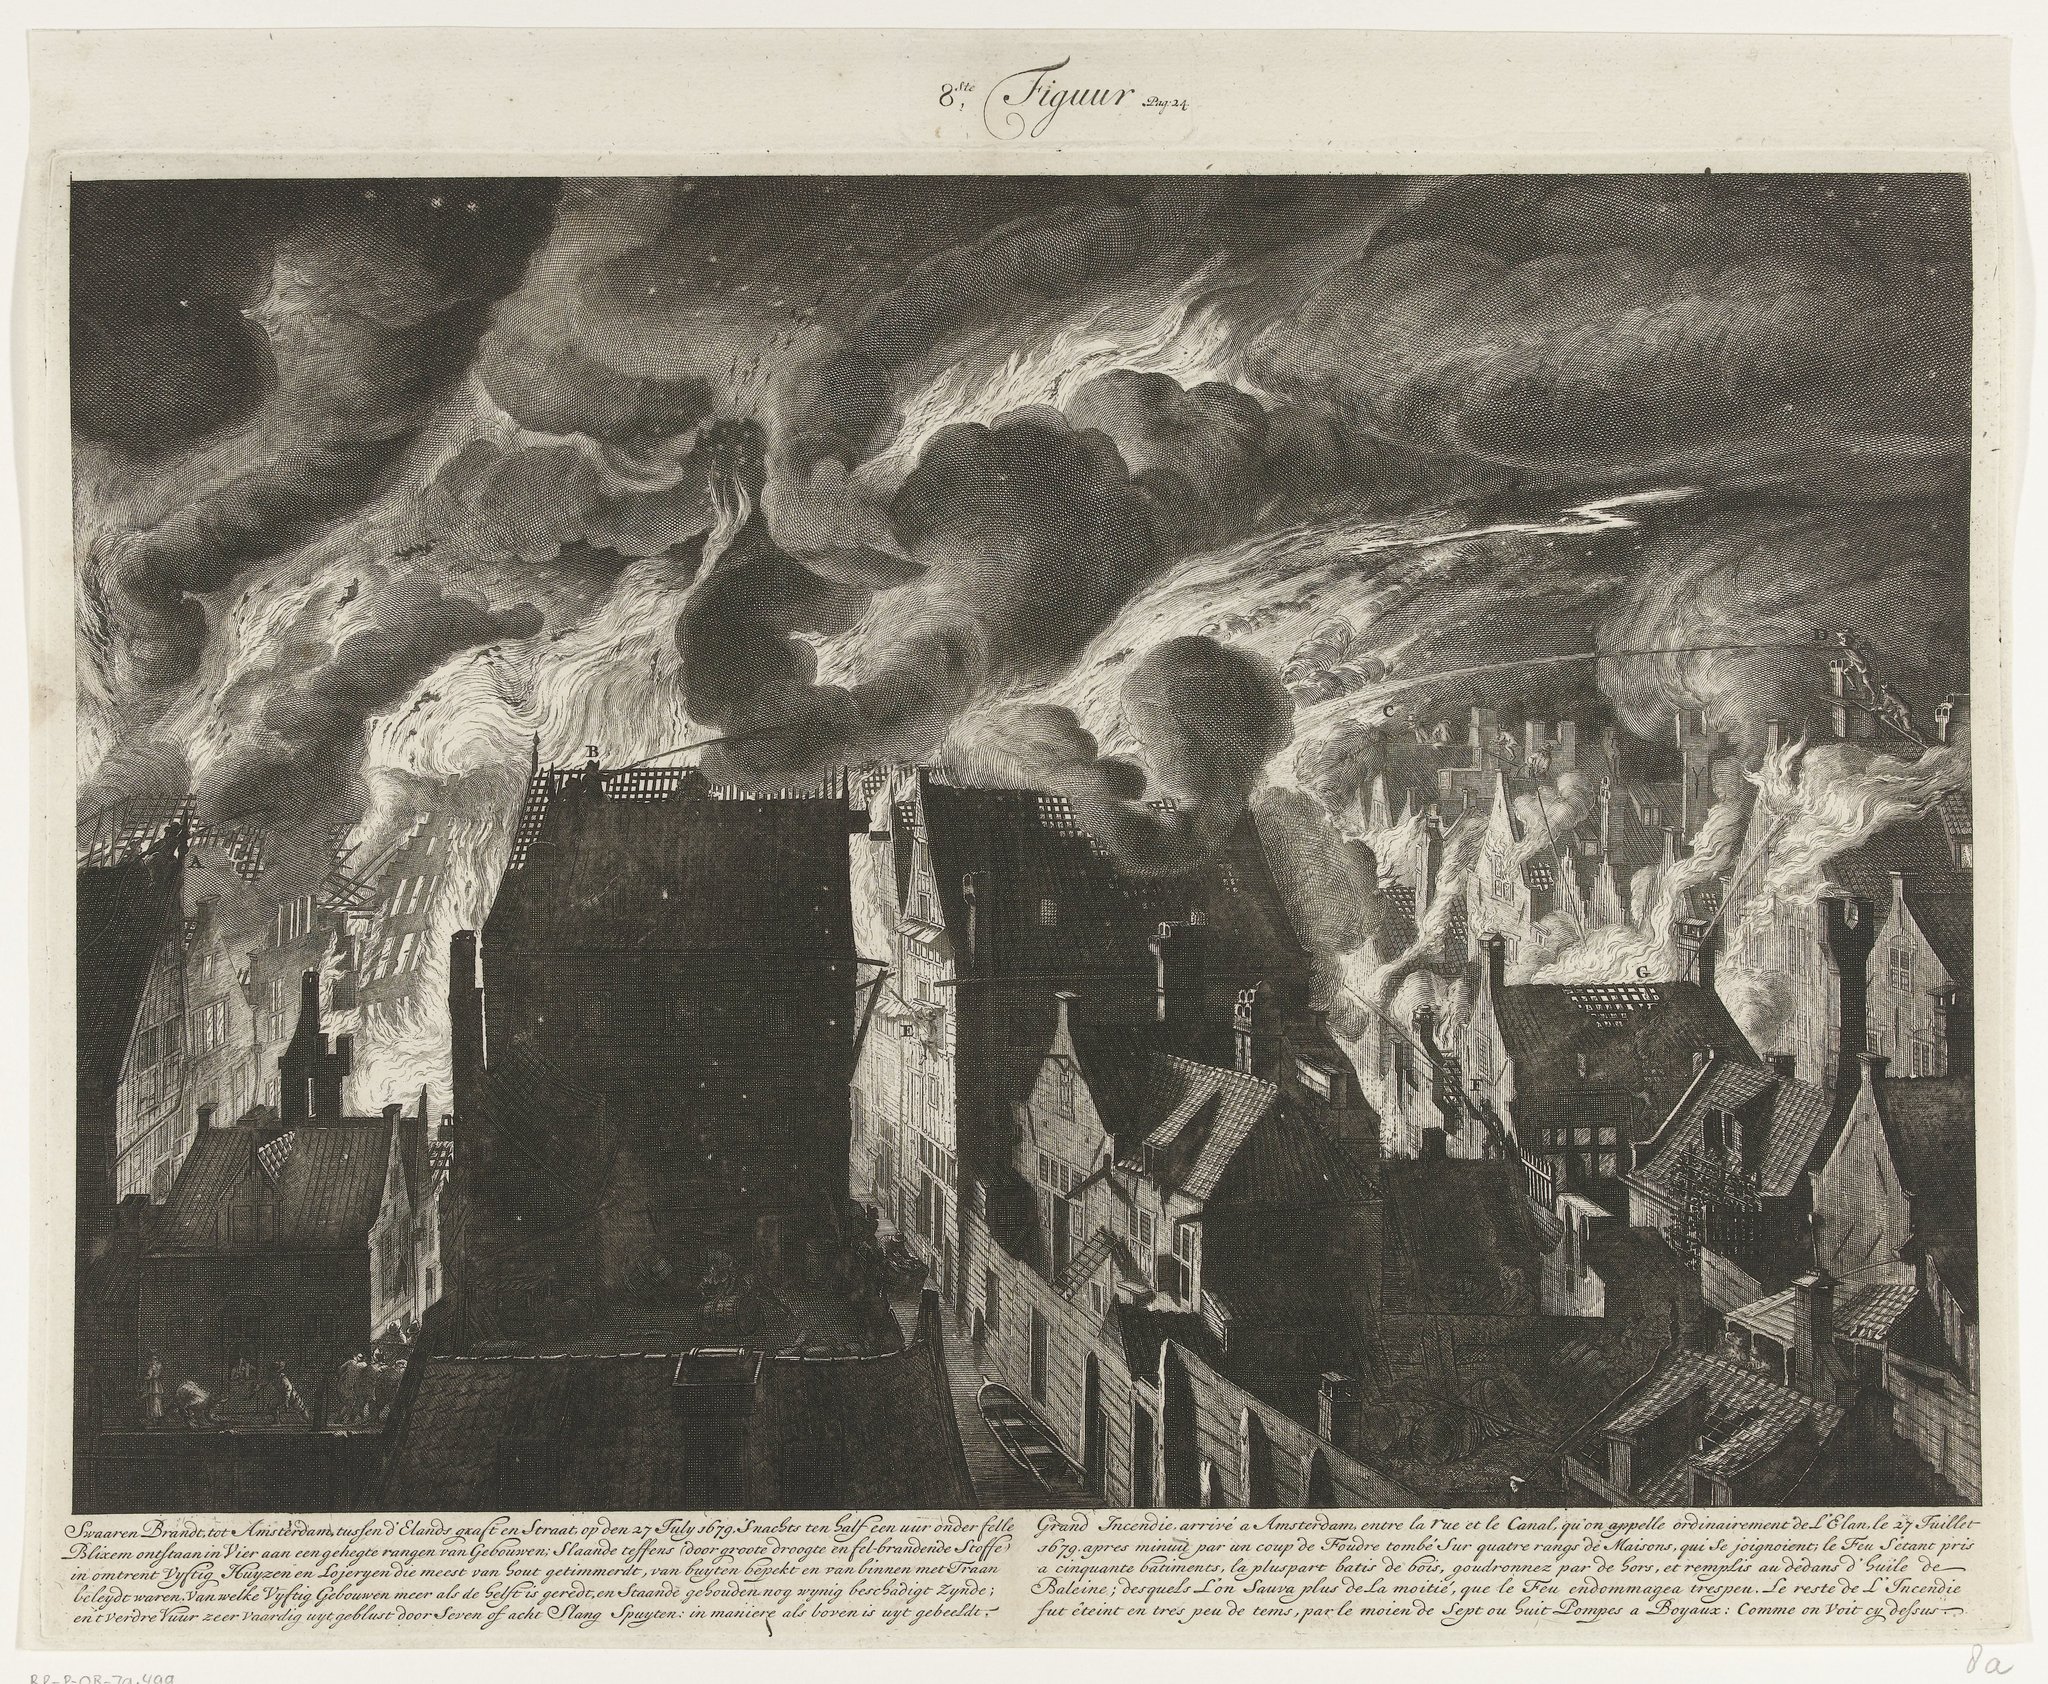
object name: book illustration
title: Het blussen van de zware brand aan de Elandsgracht, 1679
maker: jan van der heyden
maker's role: draughtsman, painter, print maker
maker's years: 1637-1712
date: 1690-1735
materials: paper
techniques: engraving, etching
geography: amsterdam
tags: painter, print maker, draughtsman, jan van der heyden, on fire, ablaze, fire-fighting, fire-extinguishing equipment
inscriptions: inscription: ‘8ste Figuur. Pag: 24’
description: Prent ook gebruikt in: Heyden, Jan van der. Beschryving der nieuwlyks uitgevonden en geoctrojeerde slang-brand-spuiten en haare wyze van brand-blussen, tegenwoordig binnen Amsterdam in gebruik zijnde (…). 1e druk. Amsterdam: Jan Rieuwertsz. (II), 1690. En in: Heyden, Jan van der. Beschryving der nieuwlyks uitgevonden en geoctrojeerde slang-brand-spuiten en haare wyze van brand-blussen, tegenwoordig binnen Amsterdam in gebruik zijnde (…). 2e druk. Amsterdam: erfgenamen Jan van der Heyden, 1735. Voor eerdere staat (voor de letter) zie RP-P-OB-82.086.